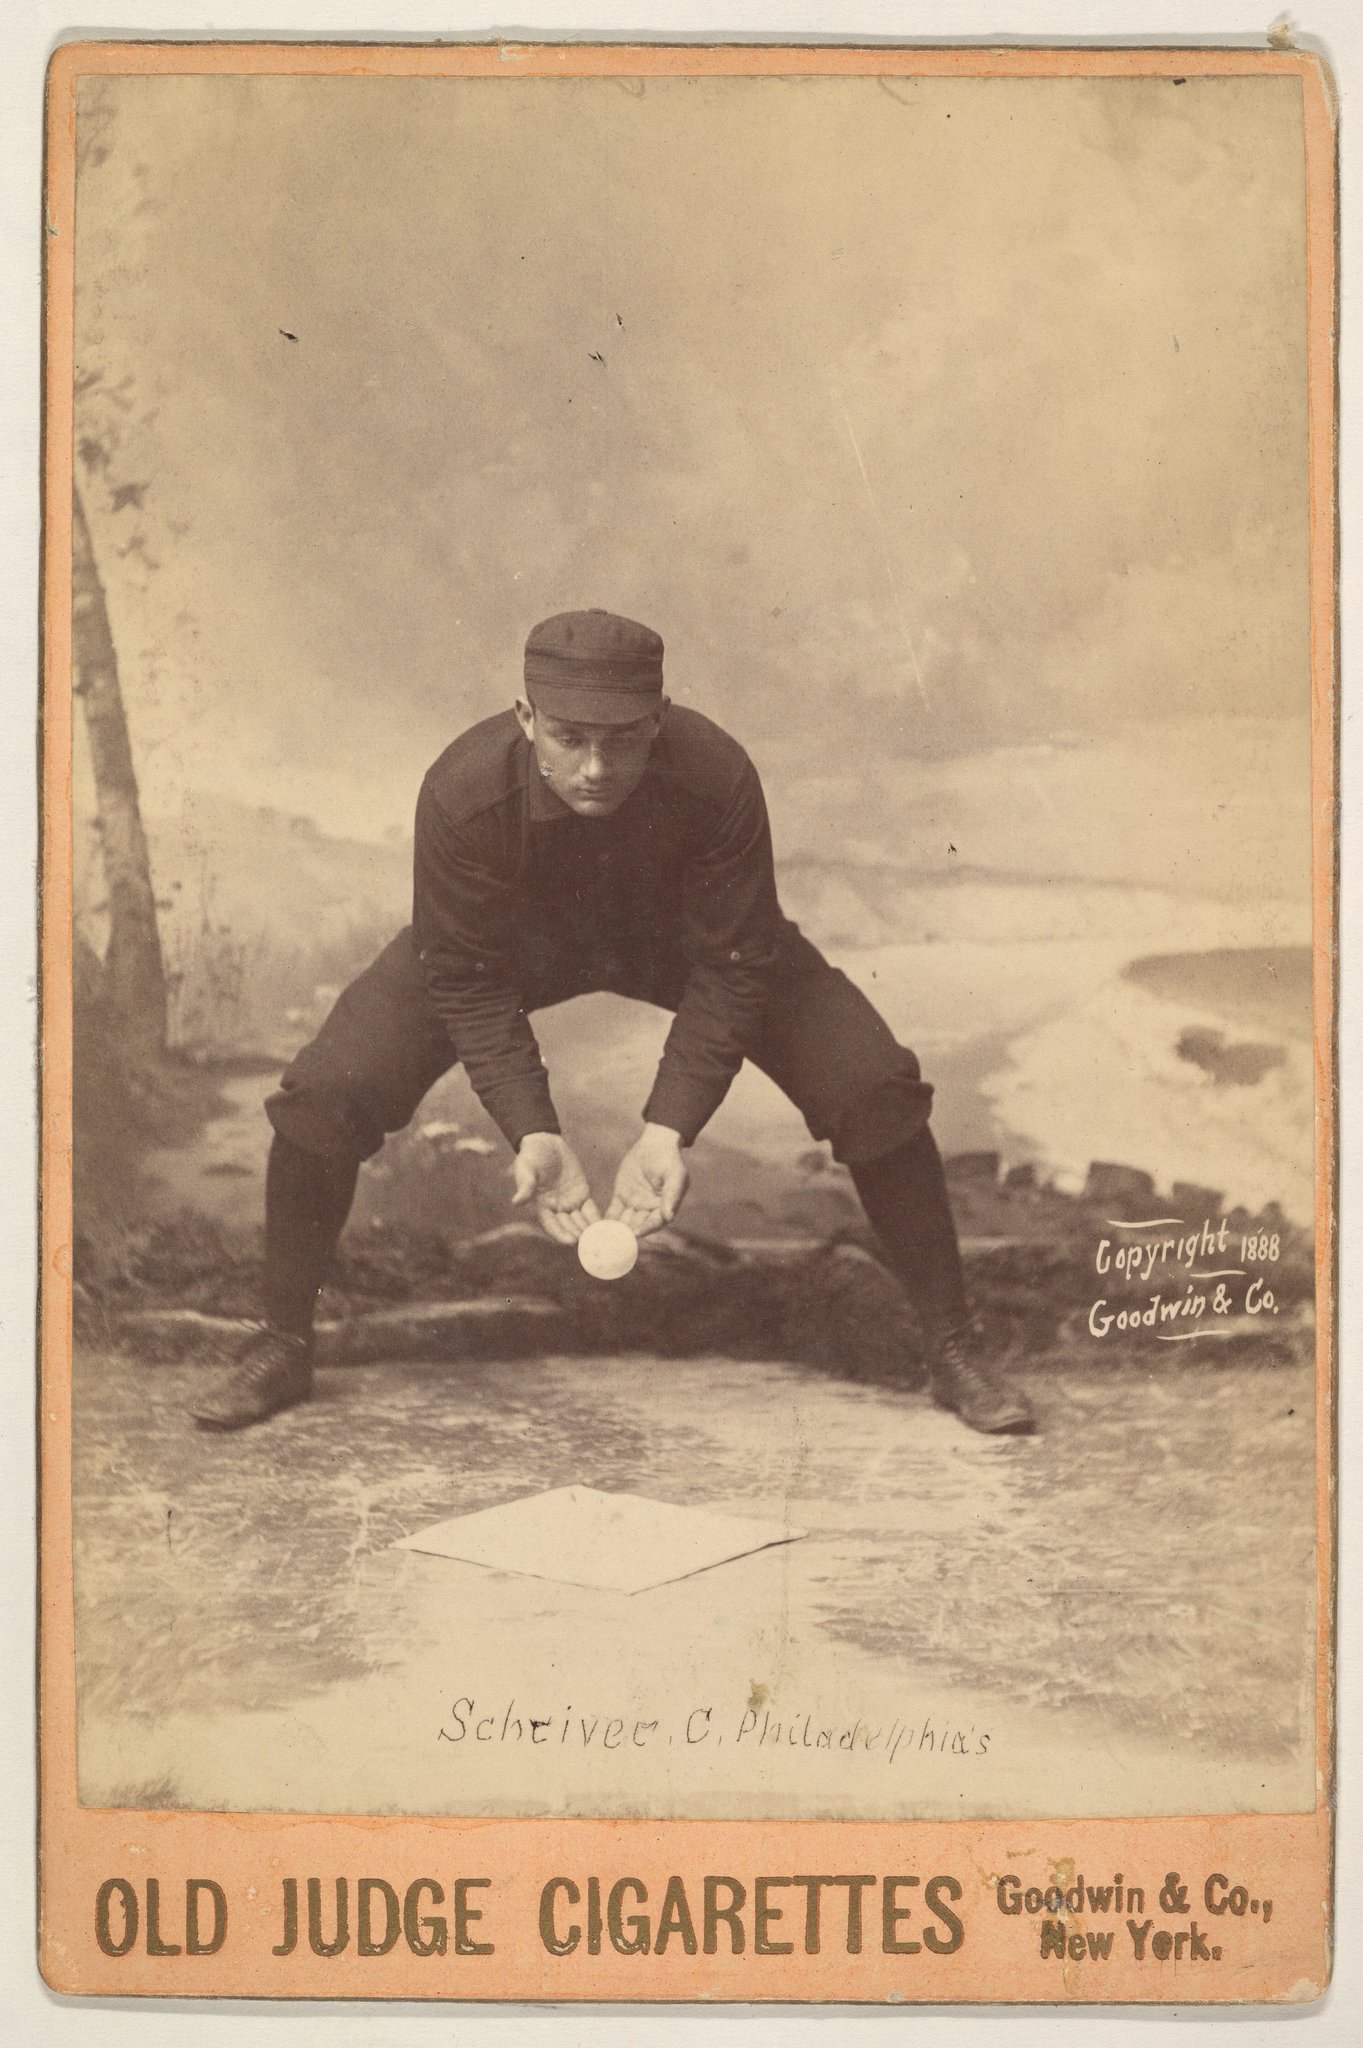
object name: baseball card, photograph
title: Schriver, Catcher, Philadelphia, from the series Old Judge Cigarettes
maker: goodwin & company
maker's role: publisher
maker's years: 1850-1950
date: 1888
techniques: albumen silver print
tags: men,portraits,baseball,athletes